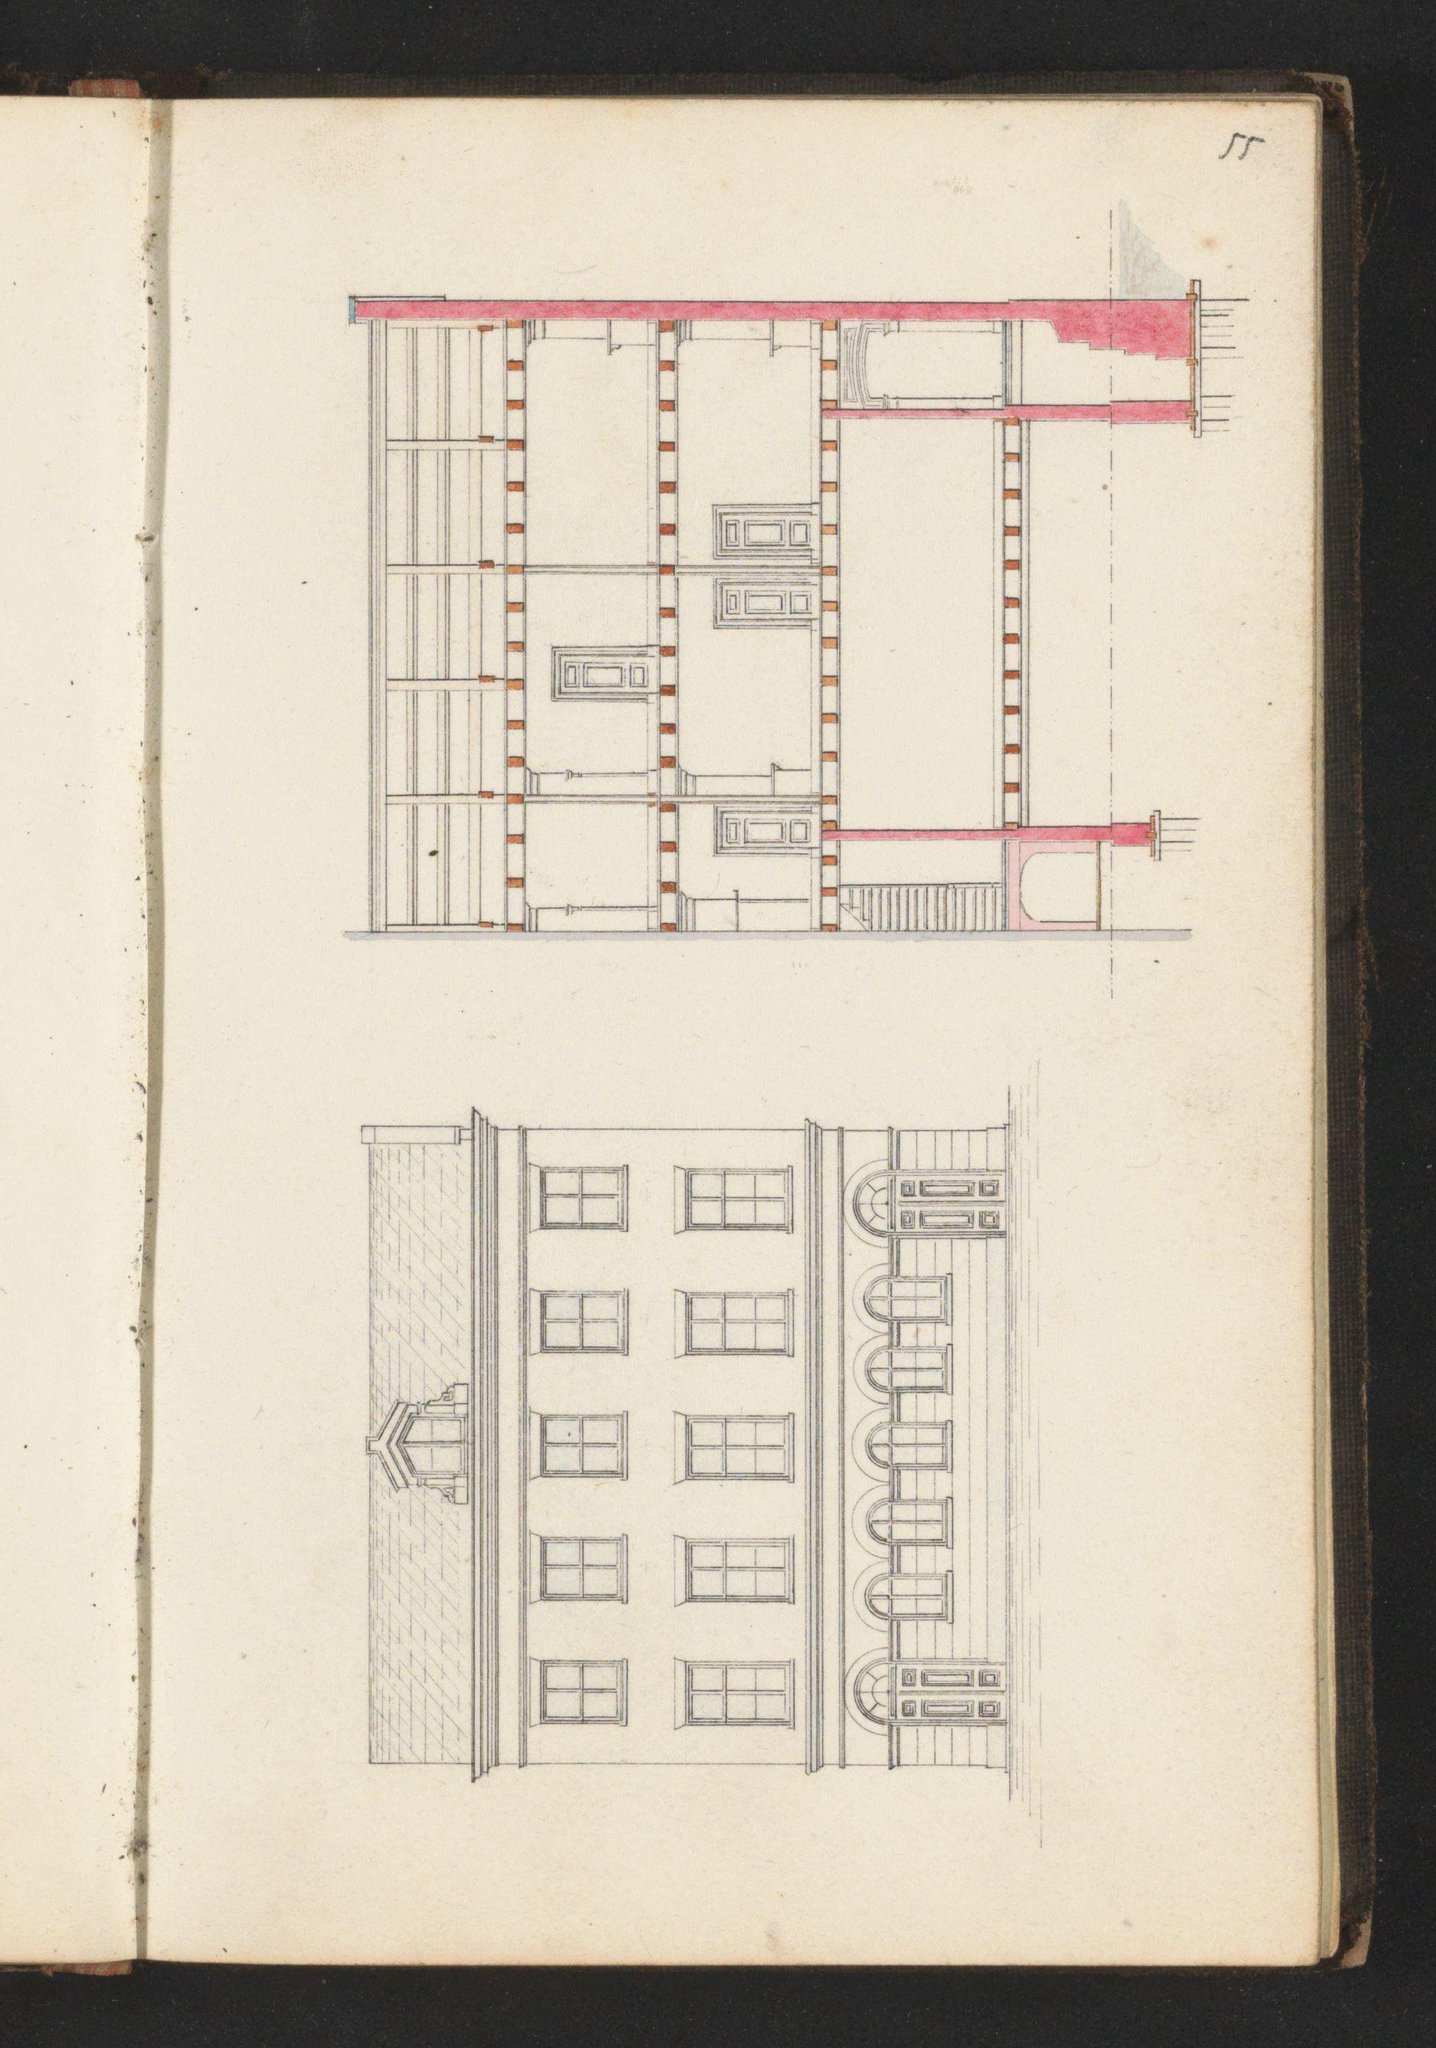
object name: sketchbook leaf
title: Façade en doorsnede van een gebouw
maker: willem springer jr.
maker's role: draughtsman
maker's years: 1815-1907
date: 1864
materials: ink, paper, watercolor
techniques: brush, pen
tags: façade (of house or building), section ~ architectural design or model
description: Pagina 55 uit een schetsboek met 164 pagina's.